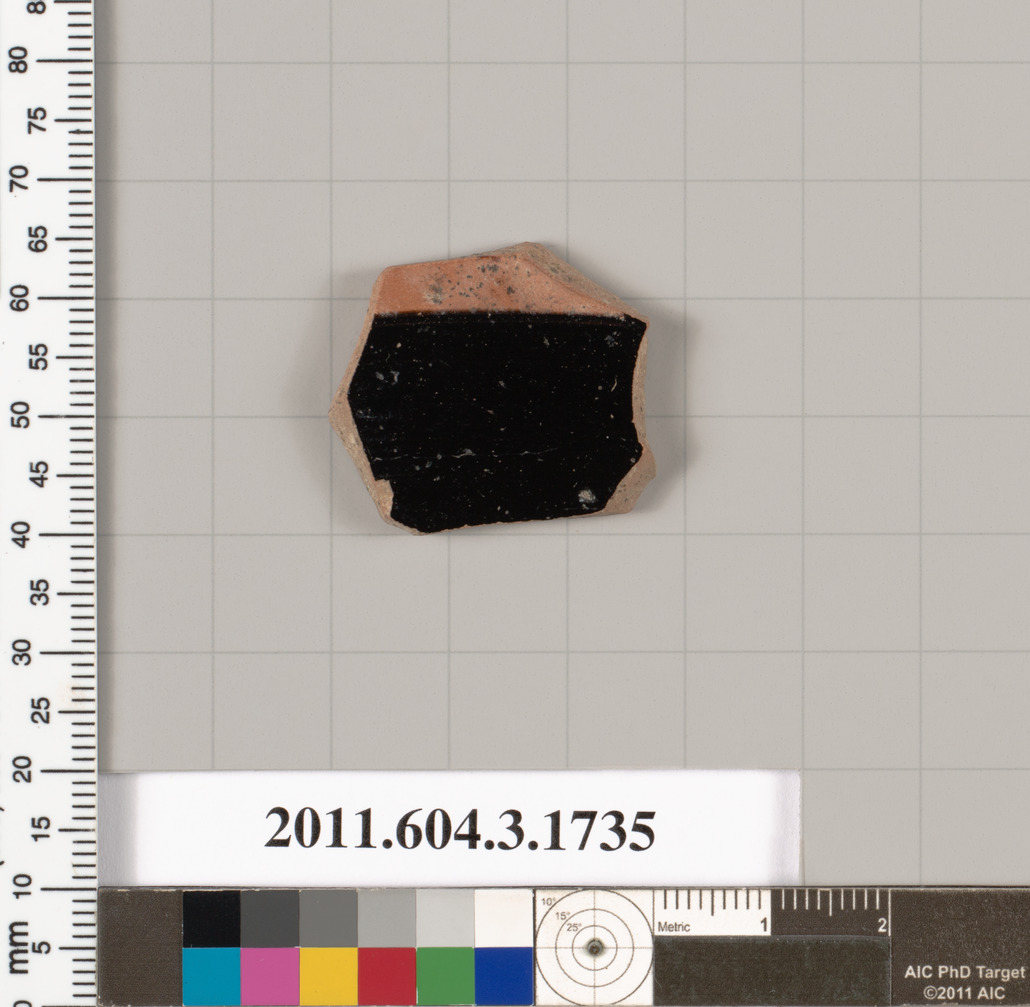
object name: kylix fragment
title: Terracotta fragment of a kylix: Band or lip cup (drinking cup)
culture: greek, attic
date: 550-526 BCE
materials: terracotta